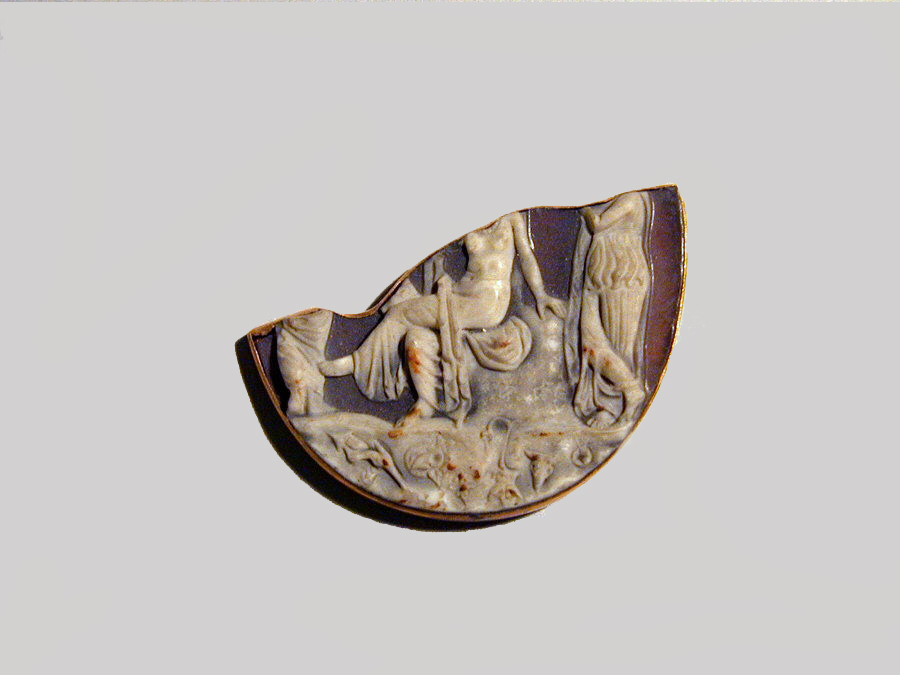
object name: cameo of a seated woman with attendant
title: Sardonyx cameo of a goddess flanked by attendants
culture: greek or roman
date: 100 BCE-100 CE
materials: gemstone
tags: women